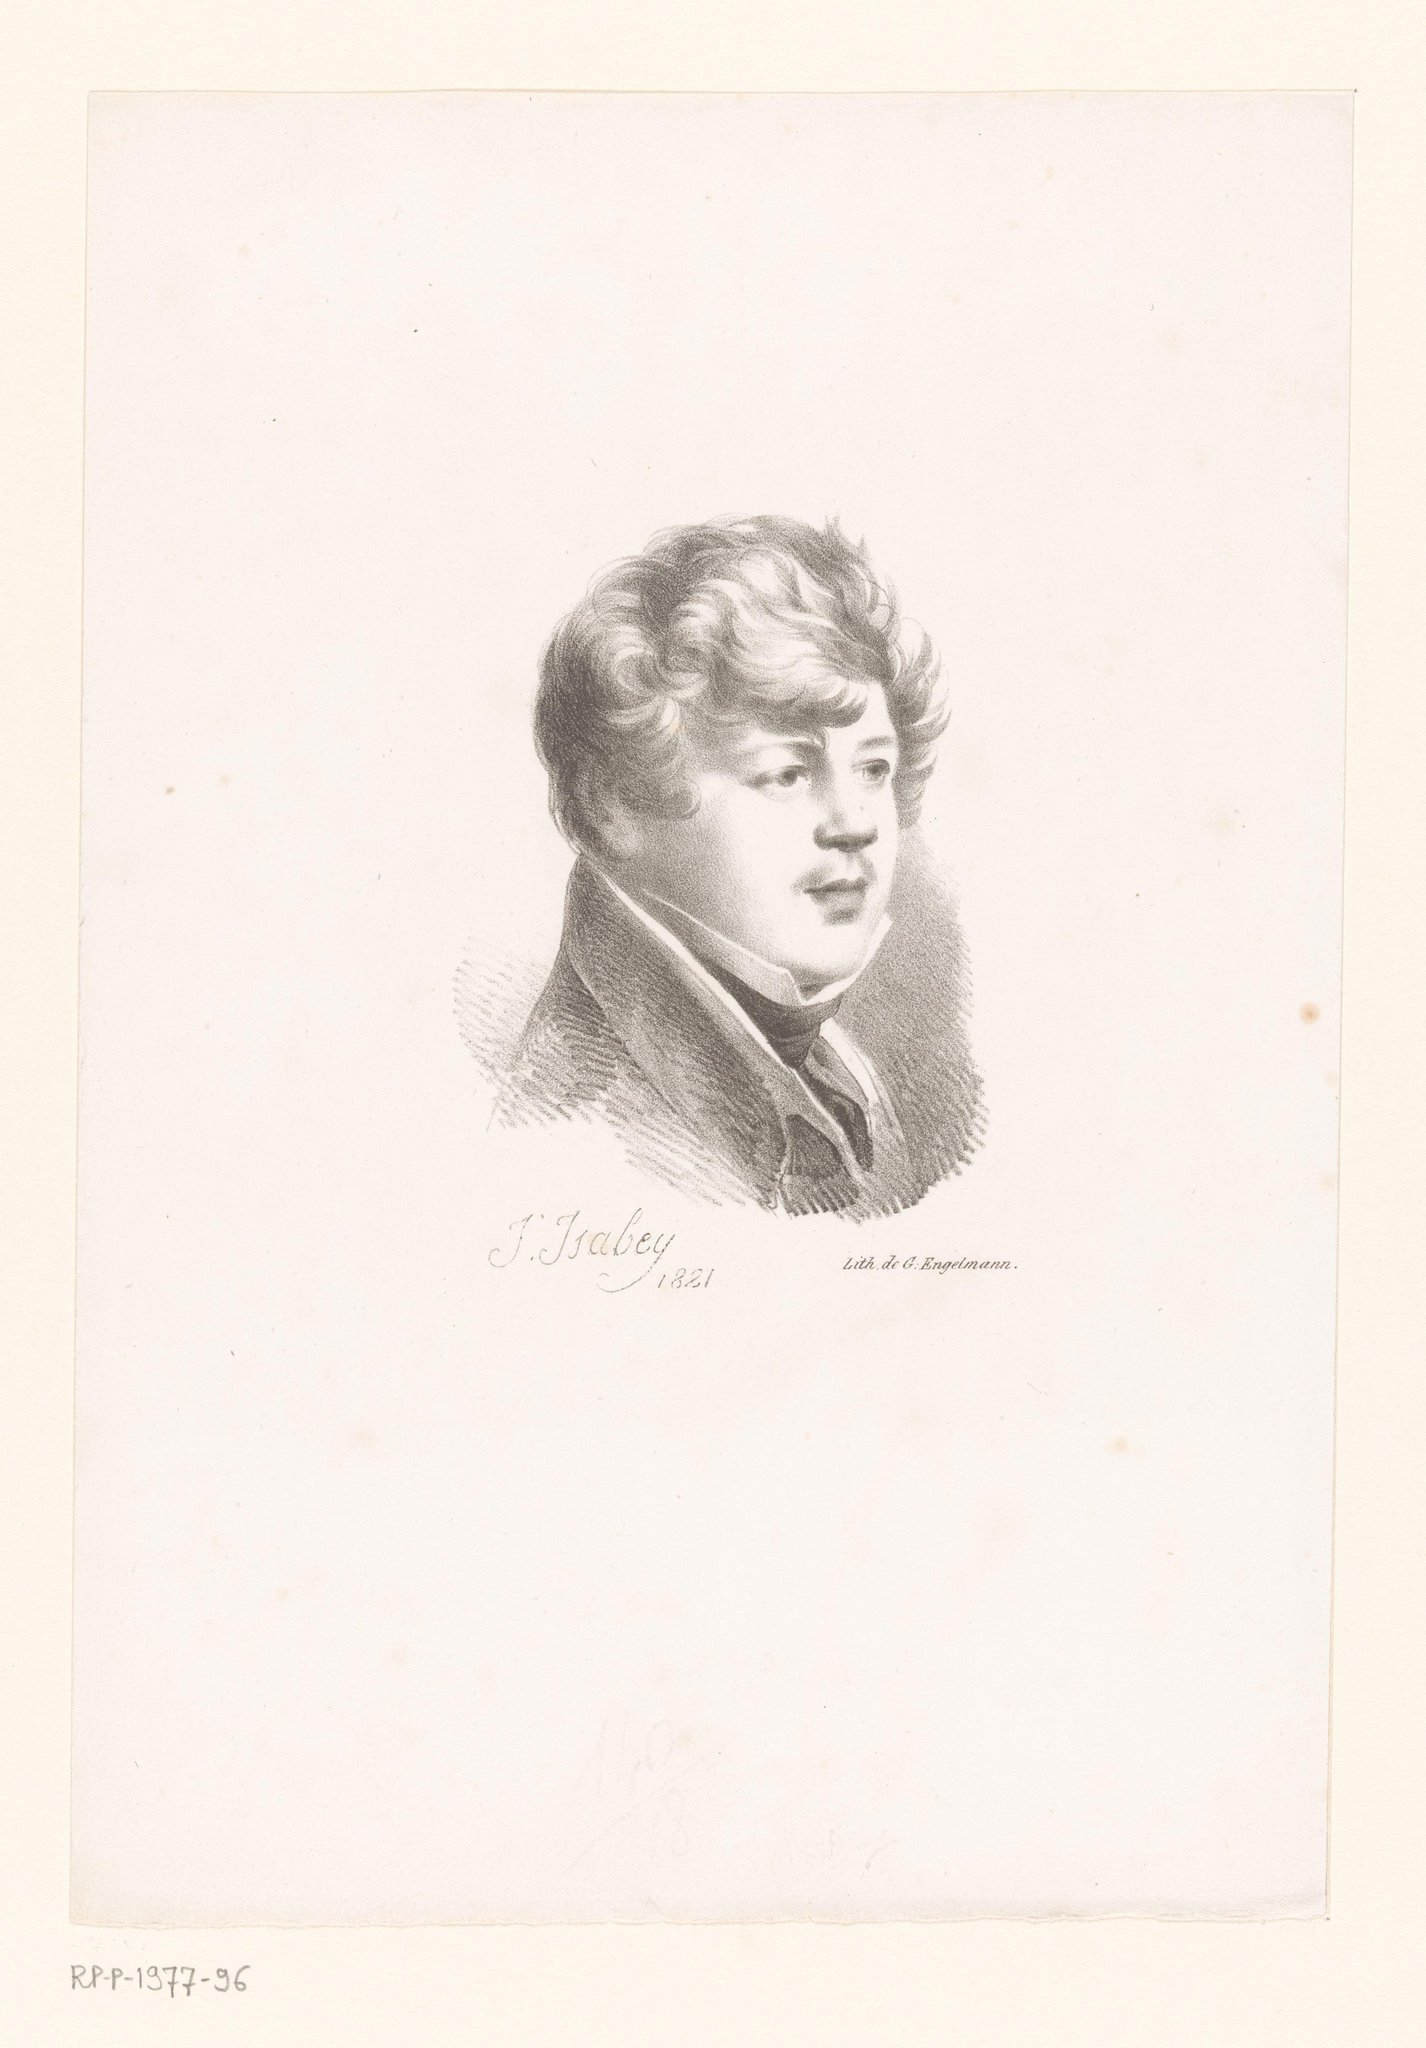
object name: print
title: Portret van Eugène Isabey op achttienjarige leeftijd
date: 1821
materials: paper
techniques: lithograph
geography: paris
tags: paris, painter, print maker, draughtsman, eugène isabey, historical persons, portrait, self-portrait of graphic artist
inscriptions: collector's mark: Lugt 2760, collector's mark: Lugt 2228a